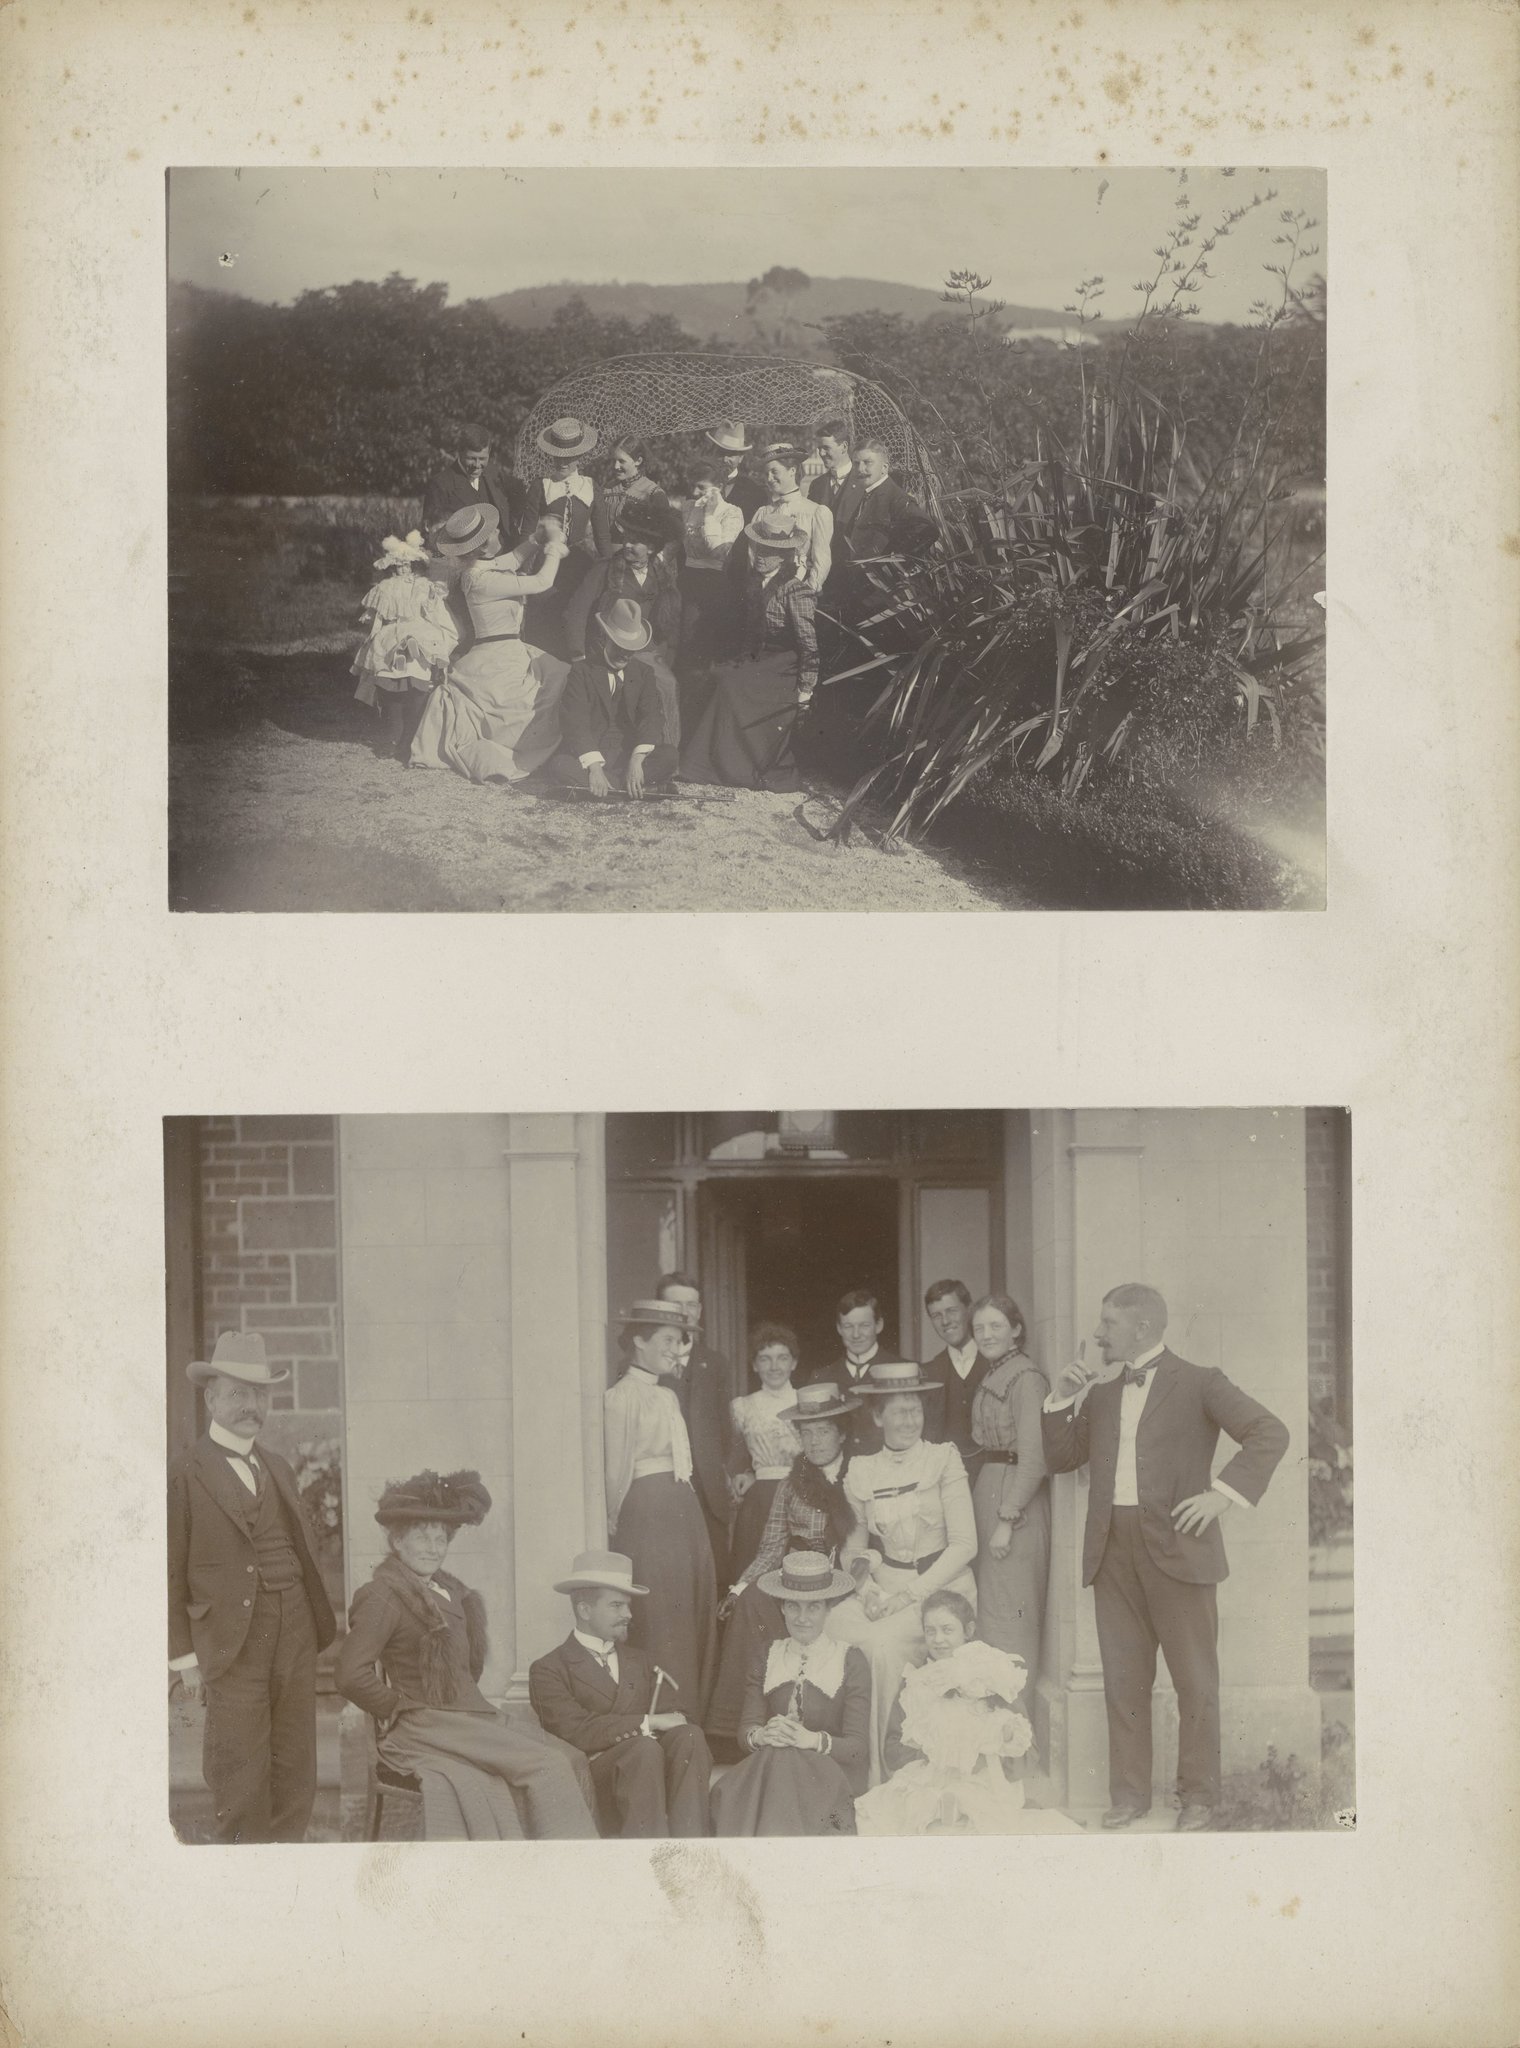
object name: album leaf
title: Groepsportret van mannen en vrouwen bij een deuropening, vermoedelijk in Sydney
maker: Anonymous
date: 1890-1910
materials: cardboard, paper, photographic support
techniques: gelatin silver print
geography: sydney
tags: adult woman, adult man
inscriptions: inscription: ‘uit map met foto's van Sydney gekocht Waterlooplein Amsterdam 1963 à f 0,10’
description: Onderdeel van Reisalbum met foto's van bezienswaardigheden in Sydney.